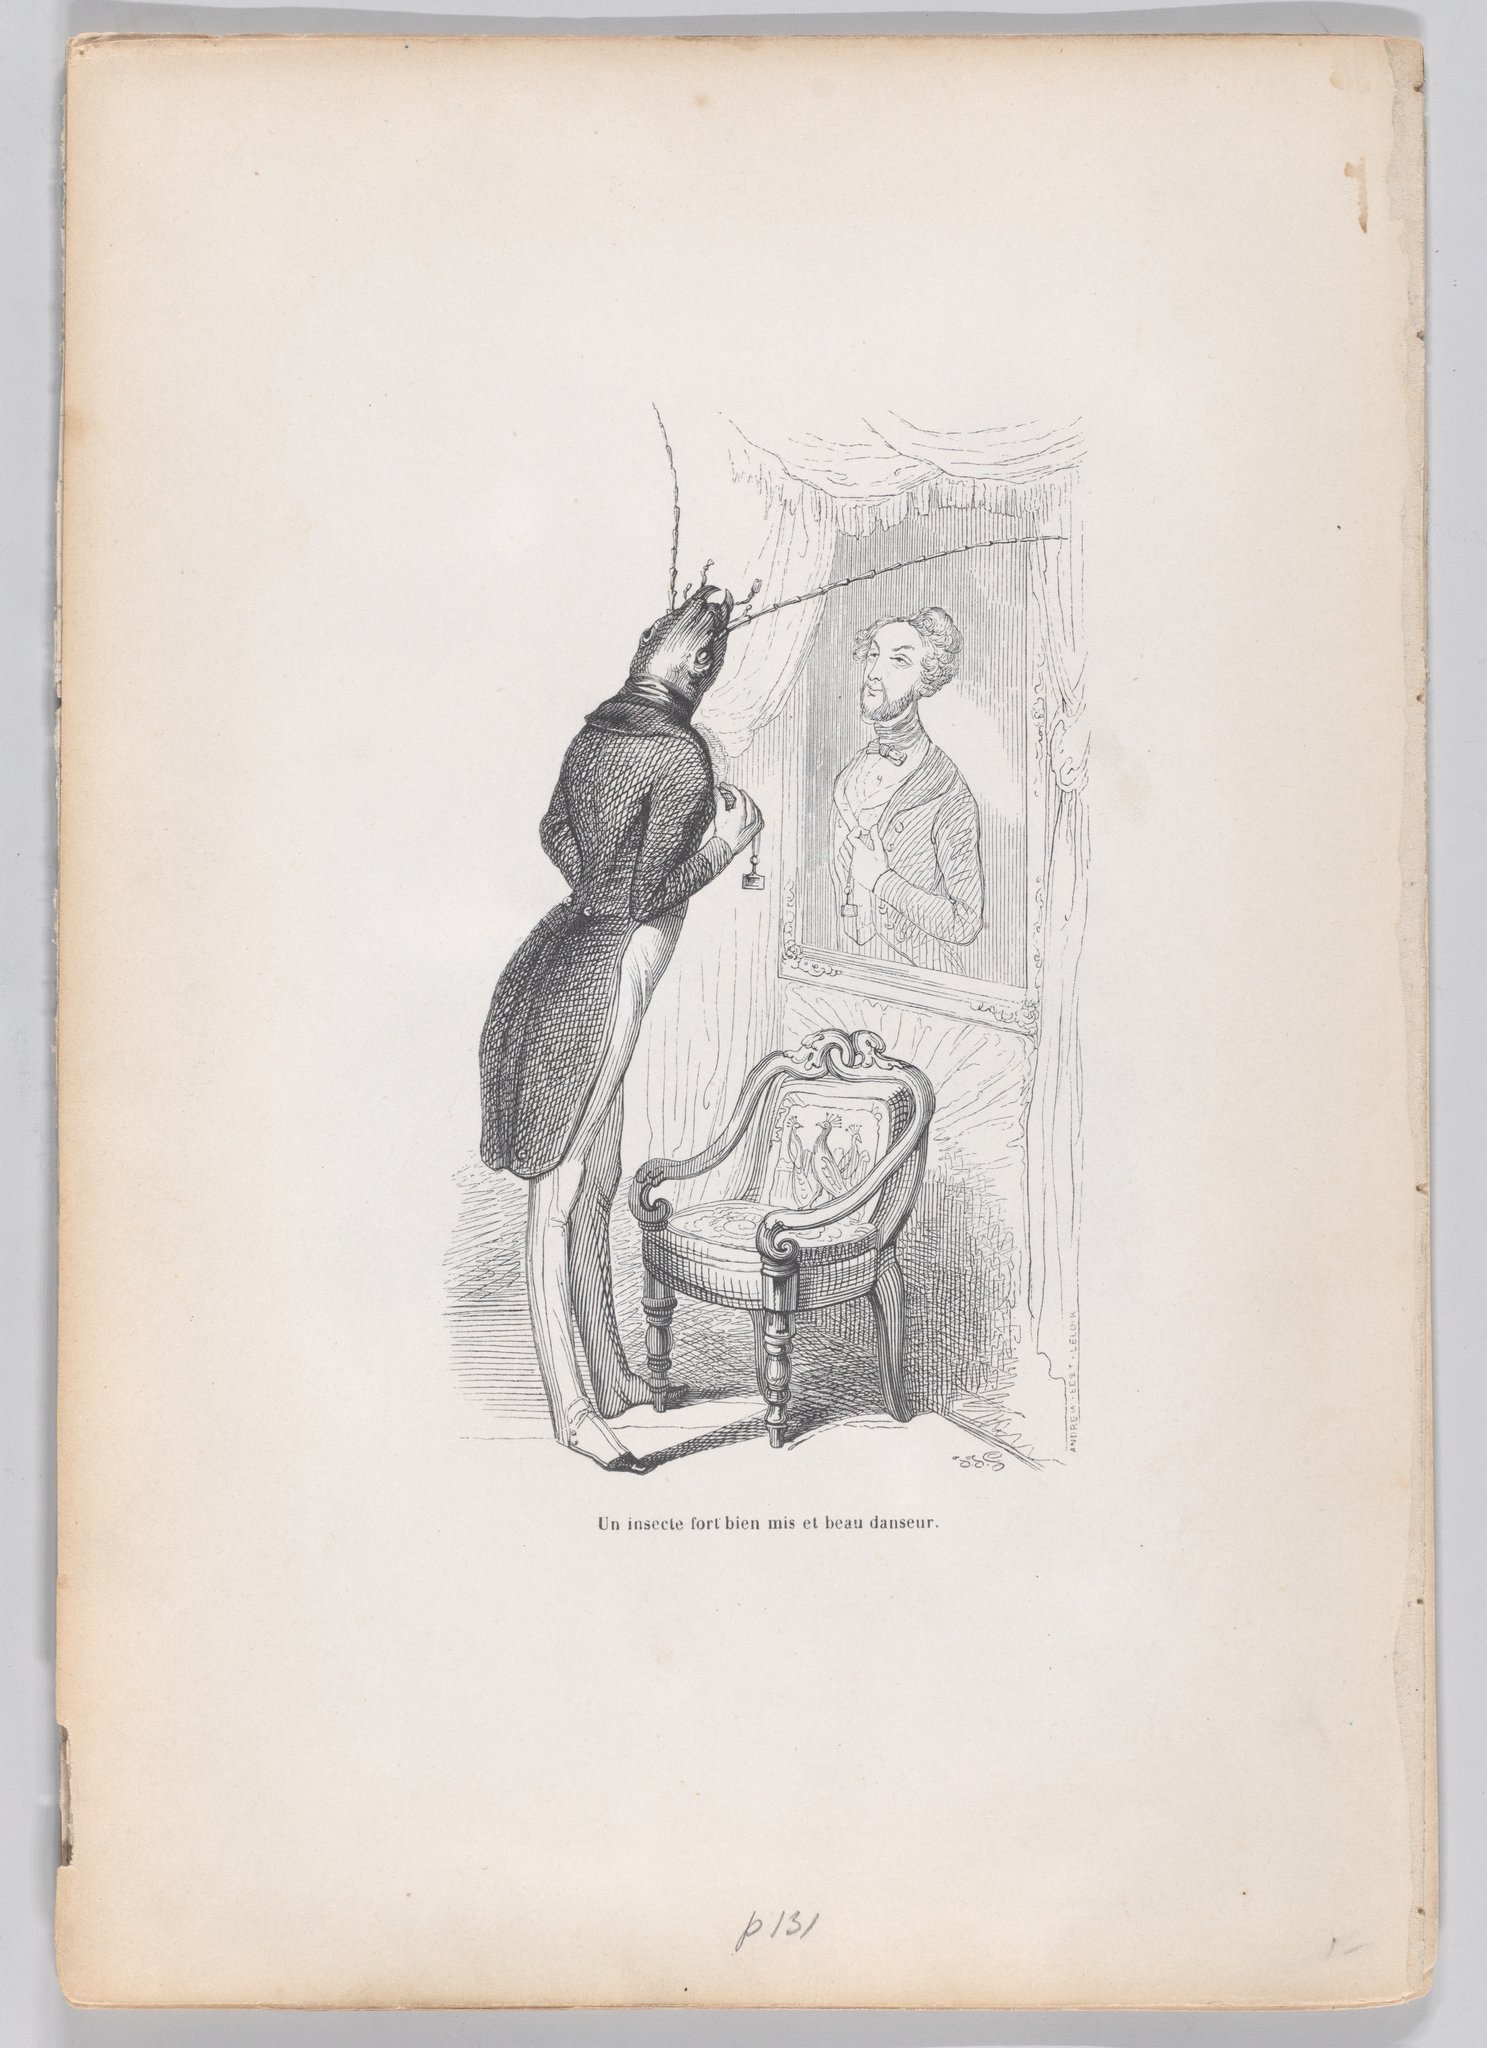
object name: print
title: A very well put insect and beautiful dancer, from "Scenes from the Private and Public Life of Animals"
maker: j. j. grandville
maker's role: illustrator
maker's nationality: french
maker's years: 1803-1847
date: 1837-1847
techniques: engraving